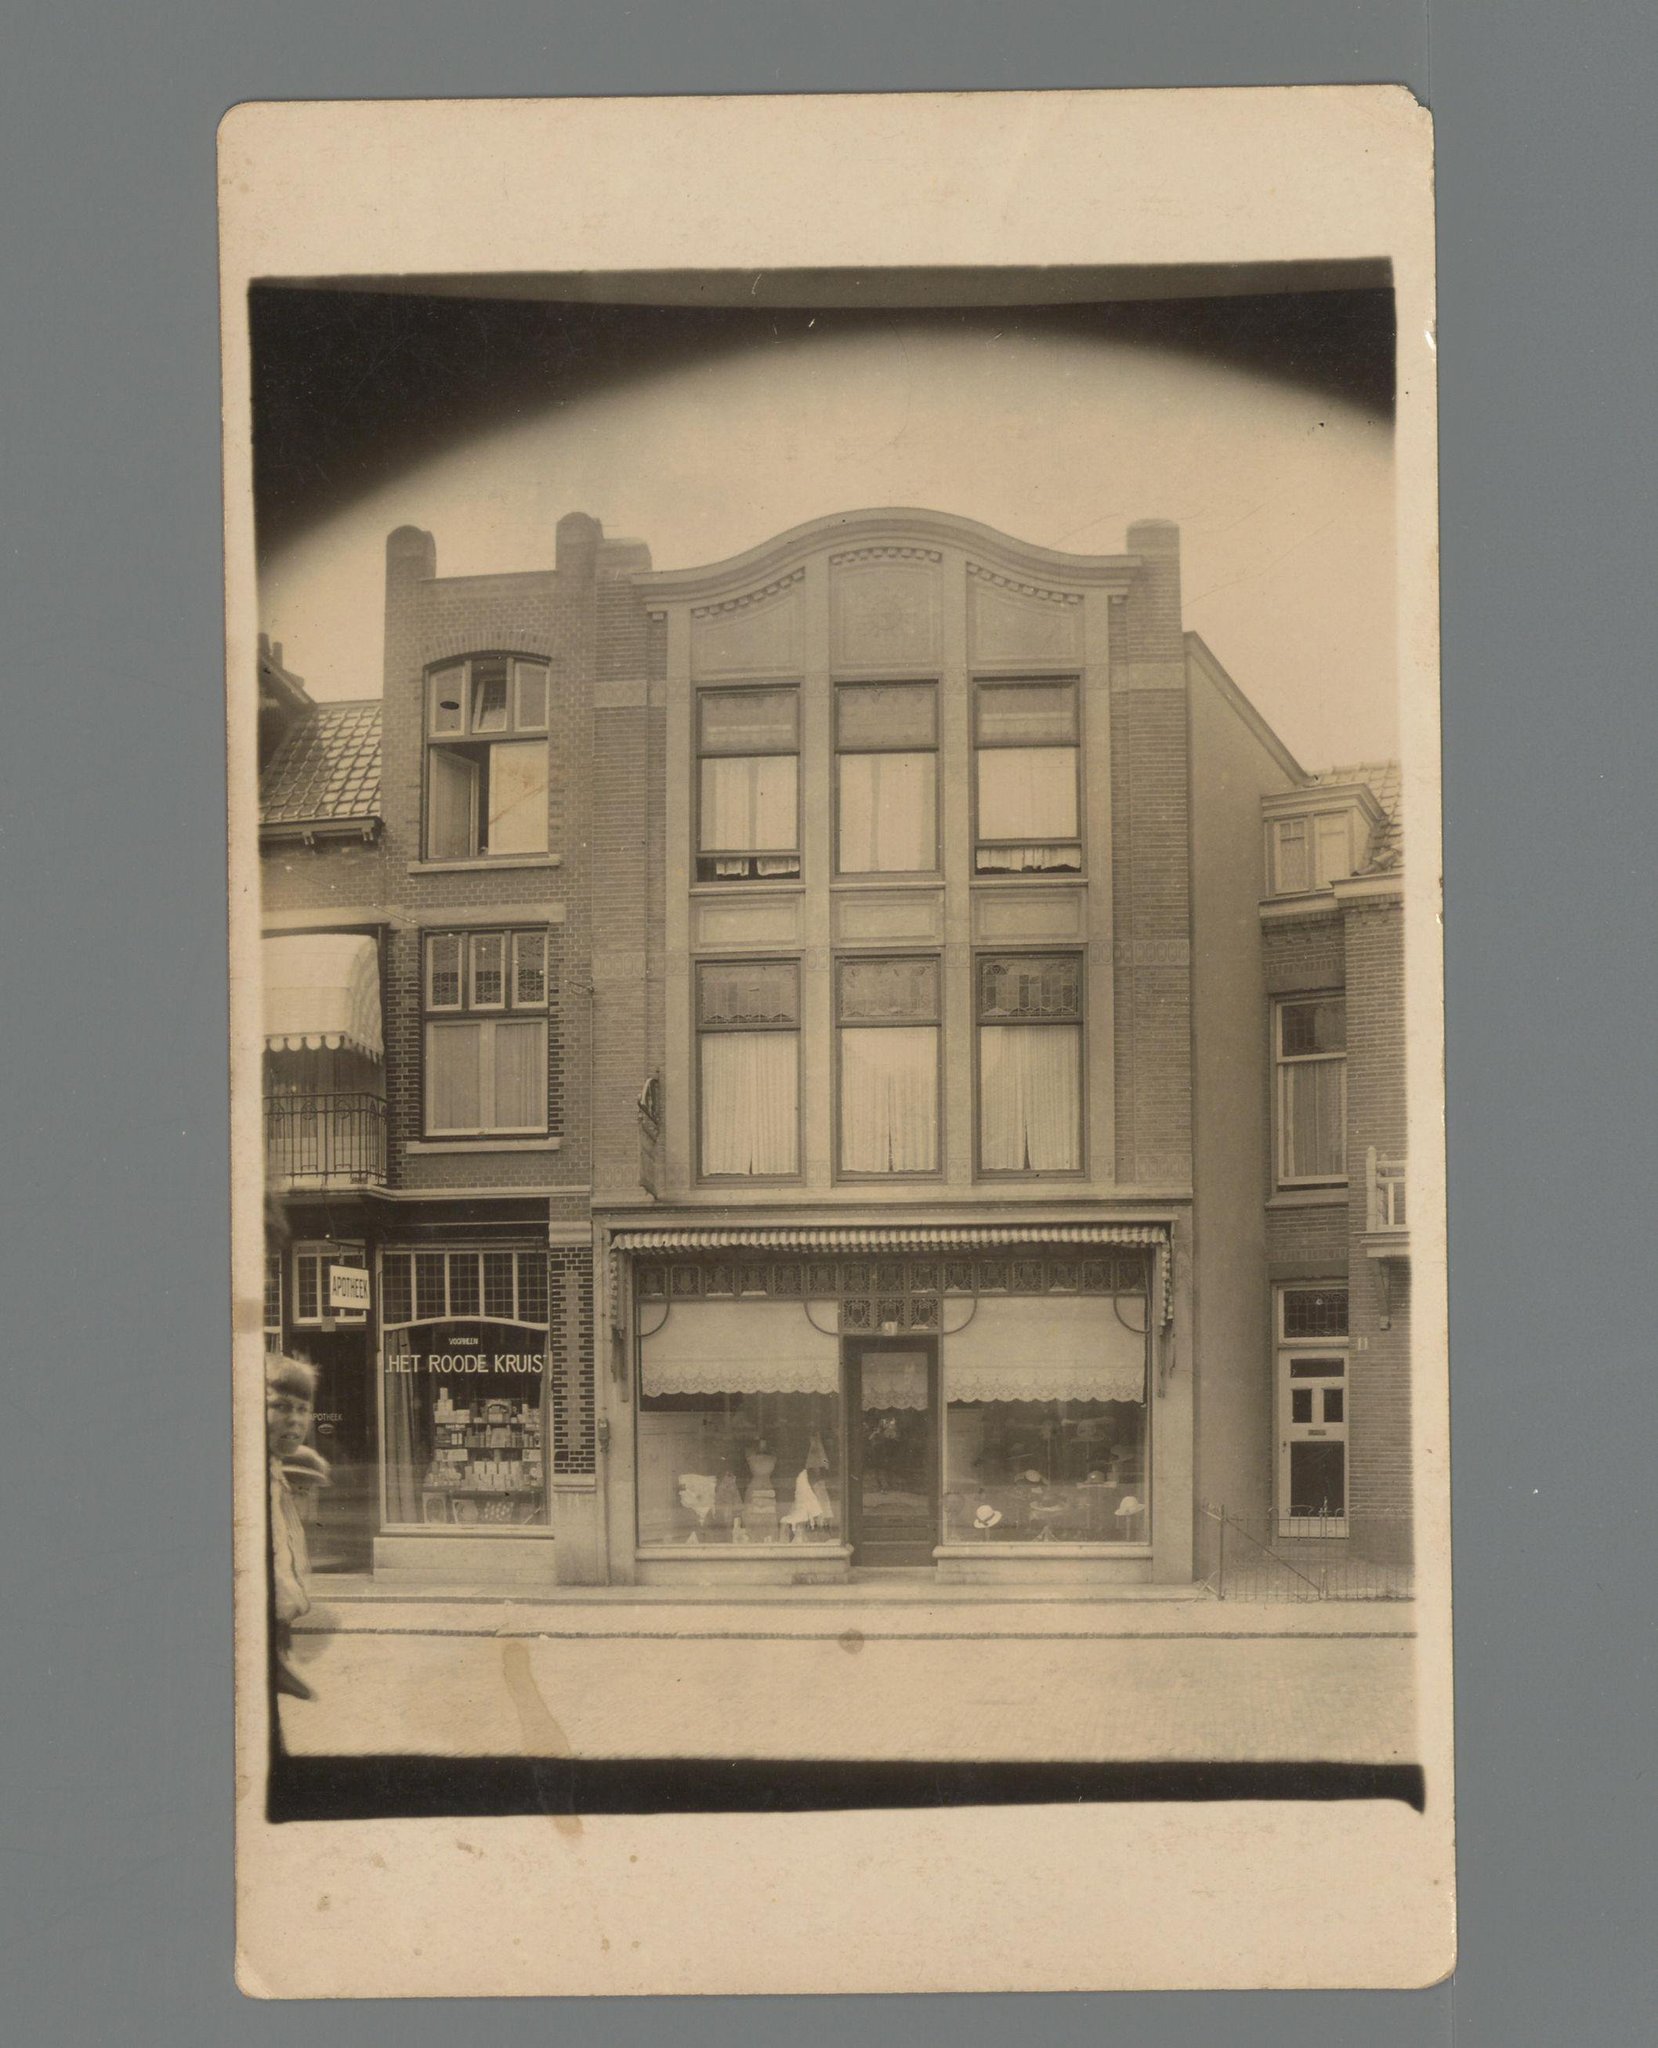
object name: photograph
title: Gebouw aan de Havenstraat in Bussum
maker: Anonymous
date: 1906-1930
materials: photographic support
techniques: gelatin silver print, writing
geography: bussum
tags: shop, store, pharmacy, pharmaceutics, street